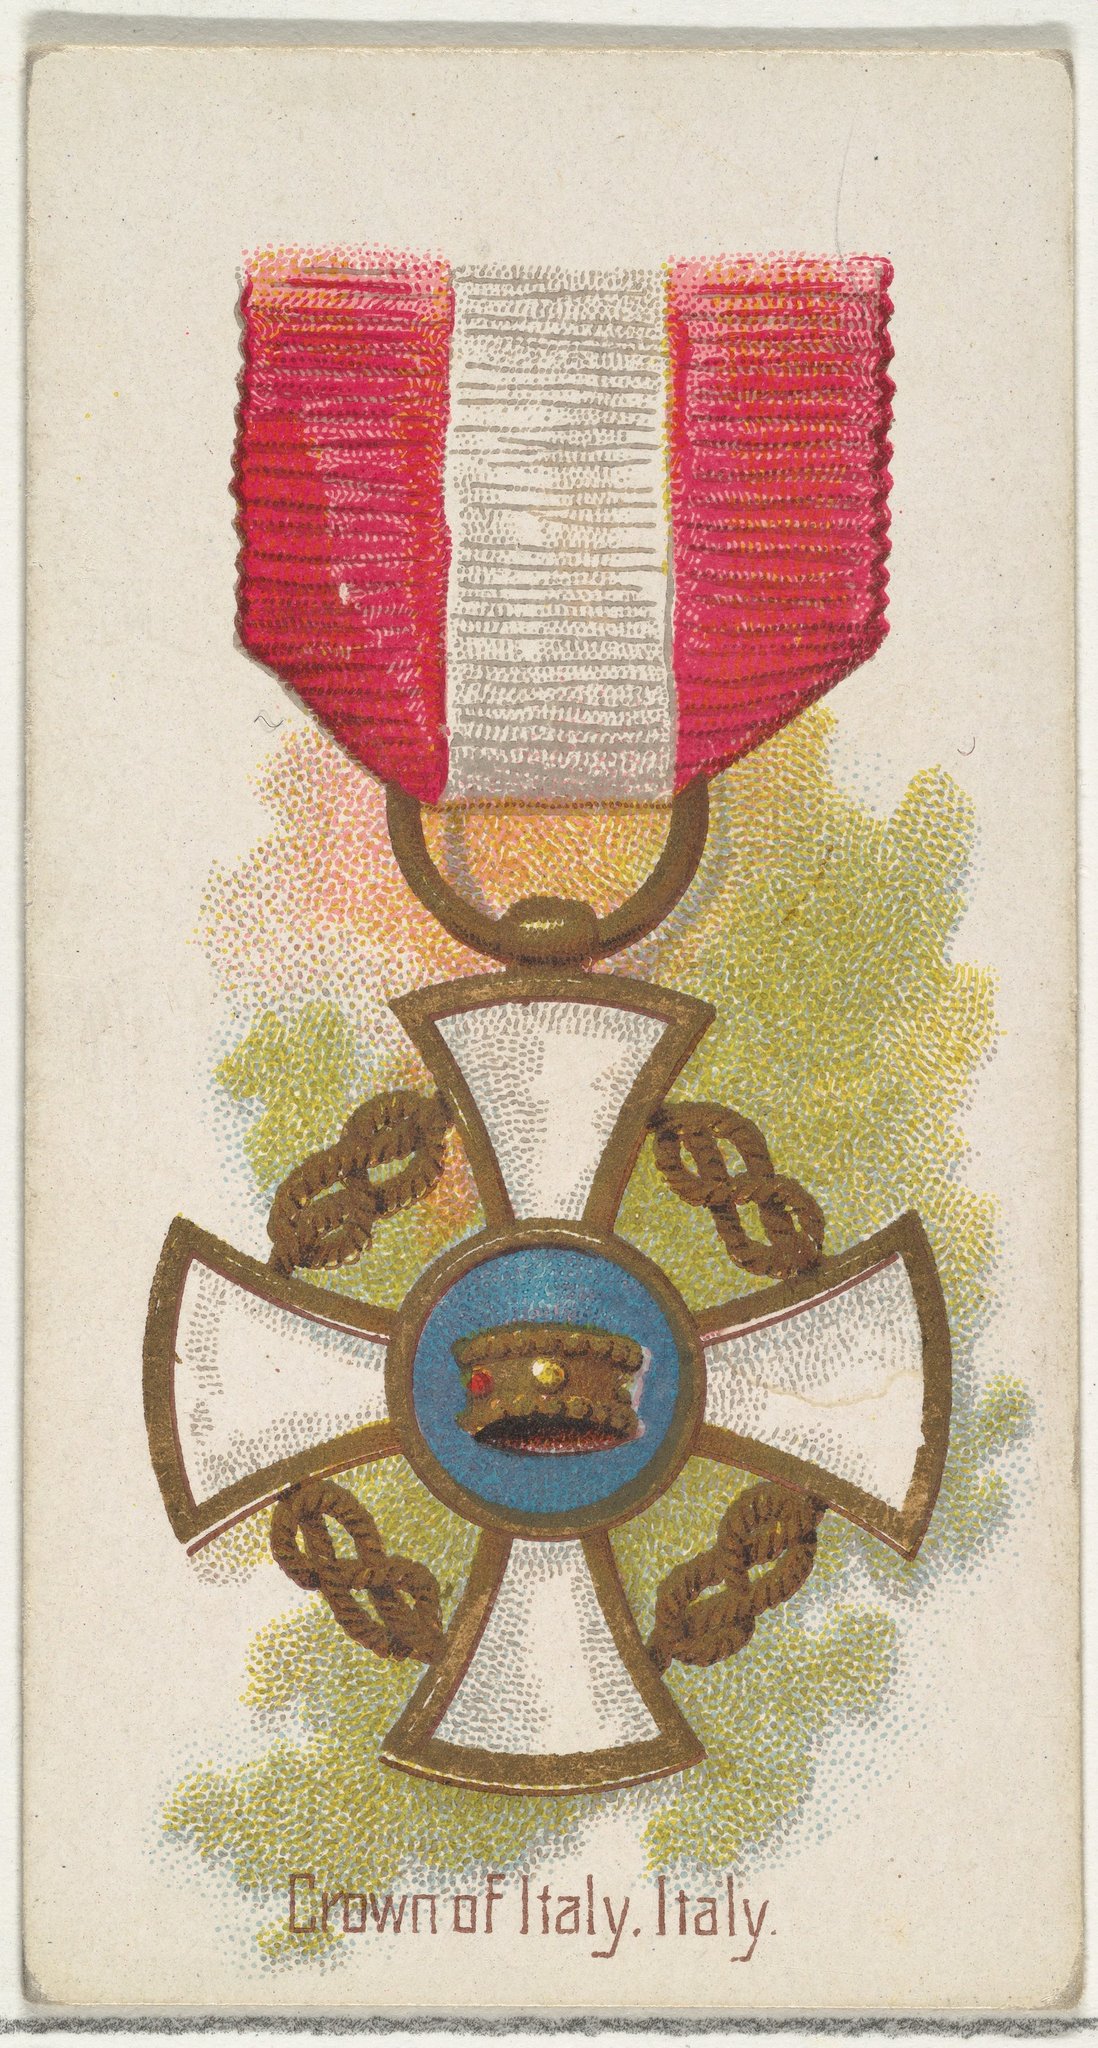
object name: print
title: Crown of Italy, Italy, from the World's Decorations series (N30) for Allen & Ginter Cigarettes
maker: allen & ginter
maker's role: publisher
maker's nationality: american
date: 1890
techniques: color lithograph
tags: medals